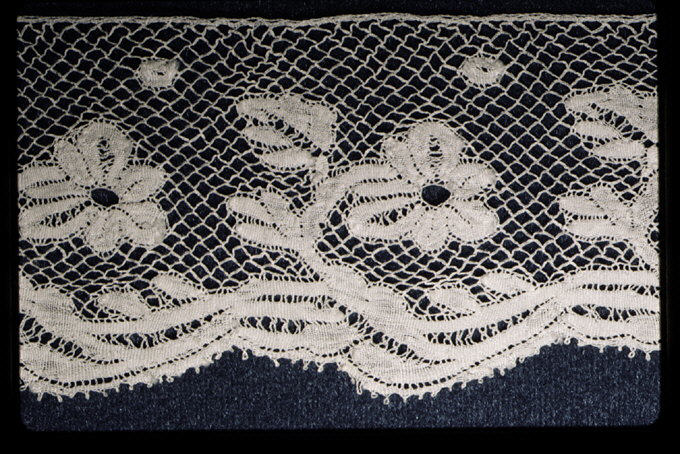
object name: piece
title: Pieces (2)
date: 1801-1900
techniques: lace